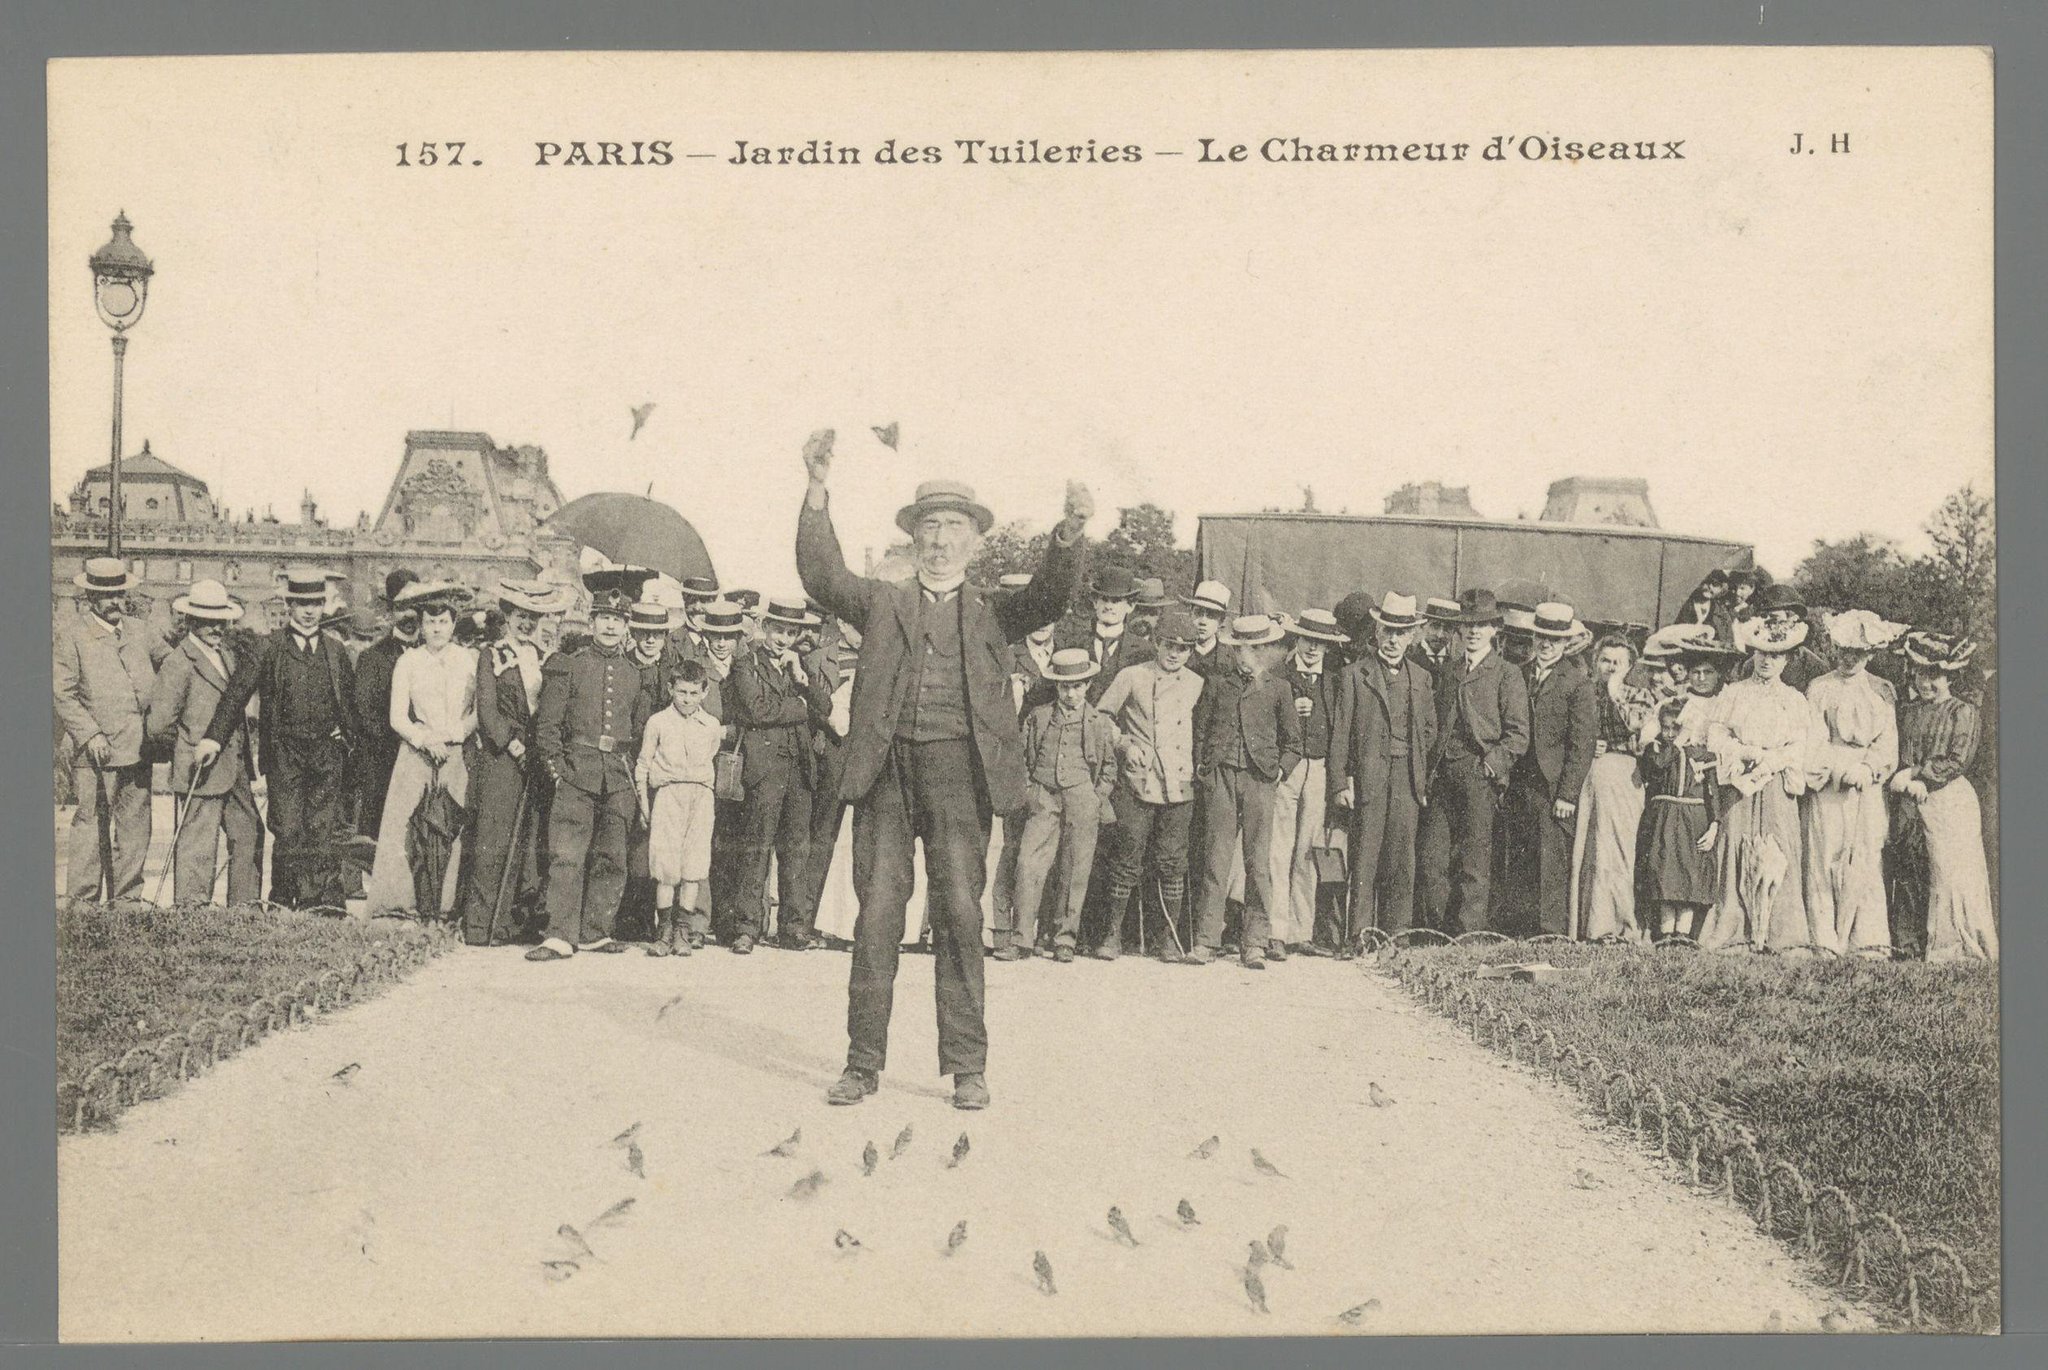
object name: photomechanical print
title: Paris. Jardin des Tuileries. Le Charmeur d'Oiseaux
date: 1904-1906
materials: cardboard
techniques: photograph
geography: paris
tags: performance, public gardens, park (+ city(-scape) with figures, staffage), birds